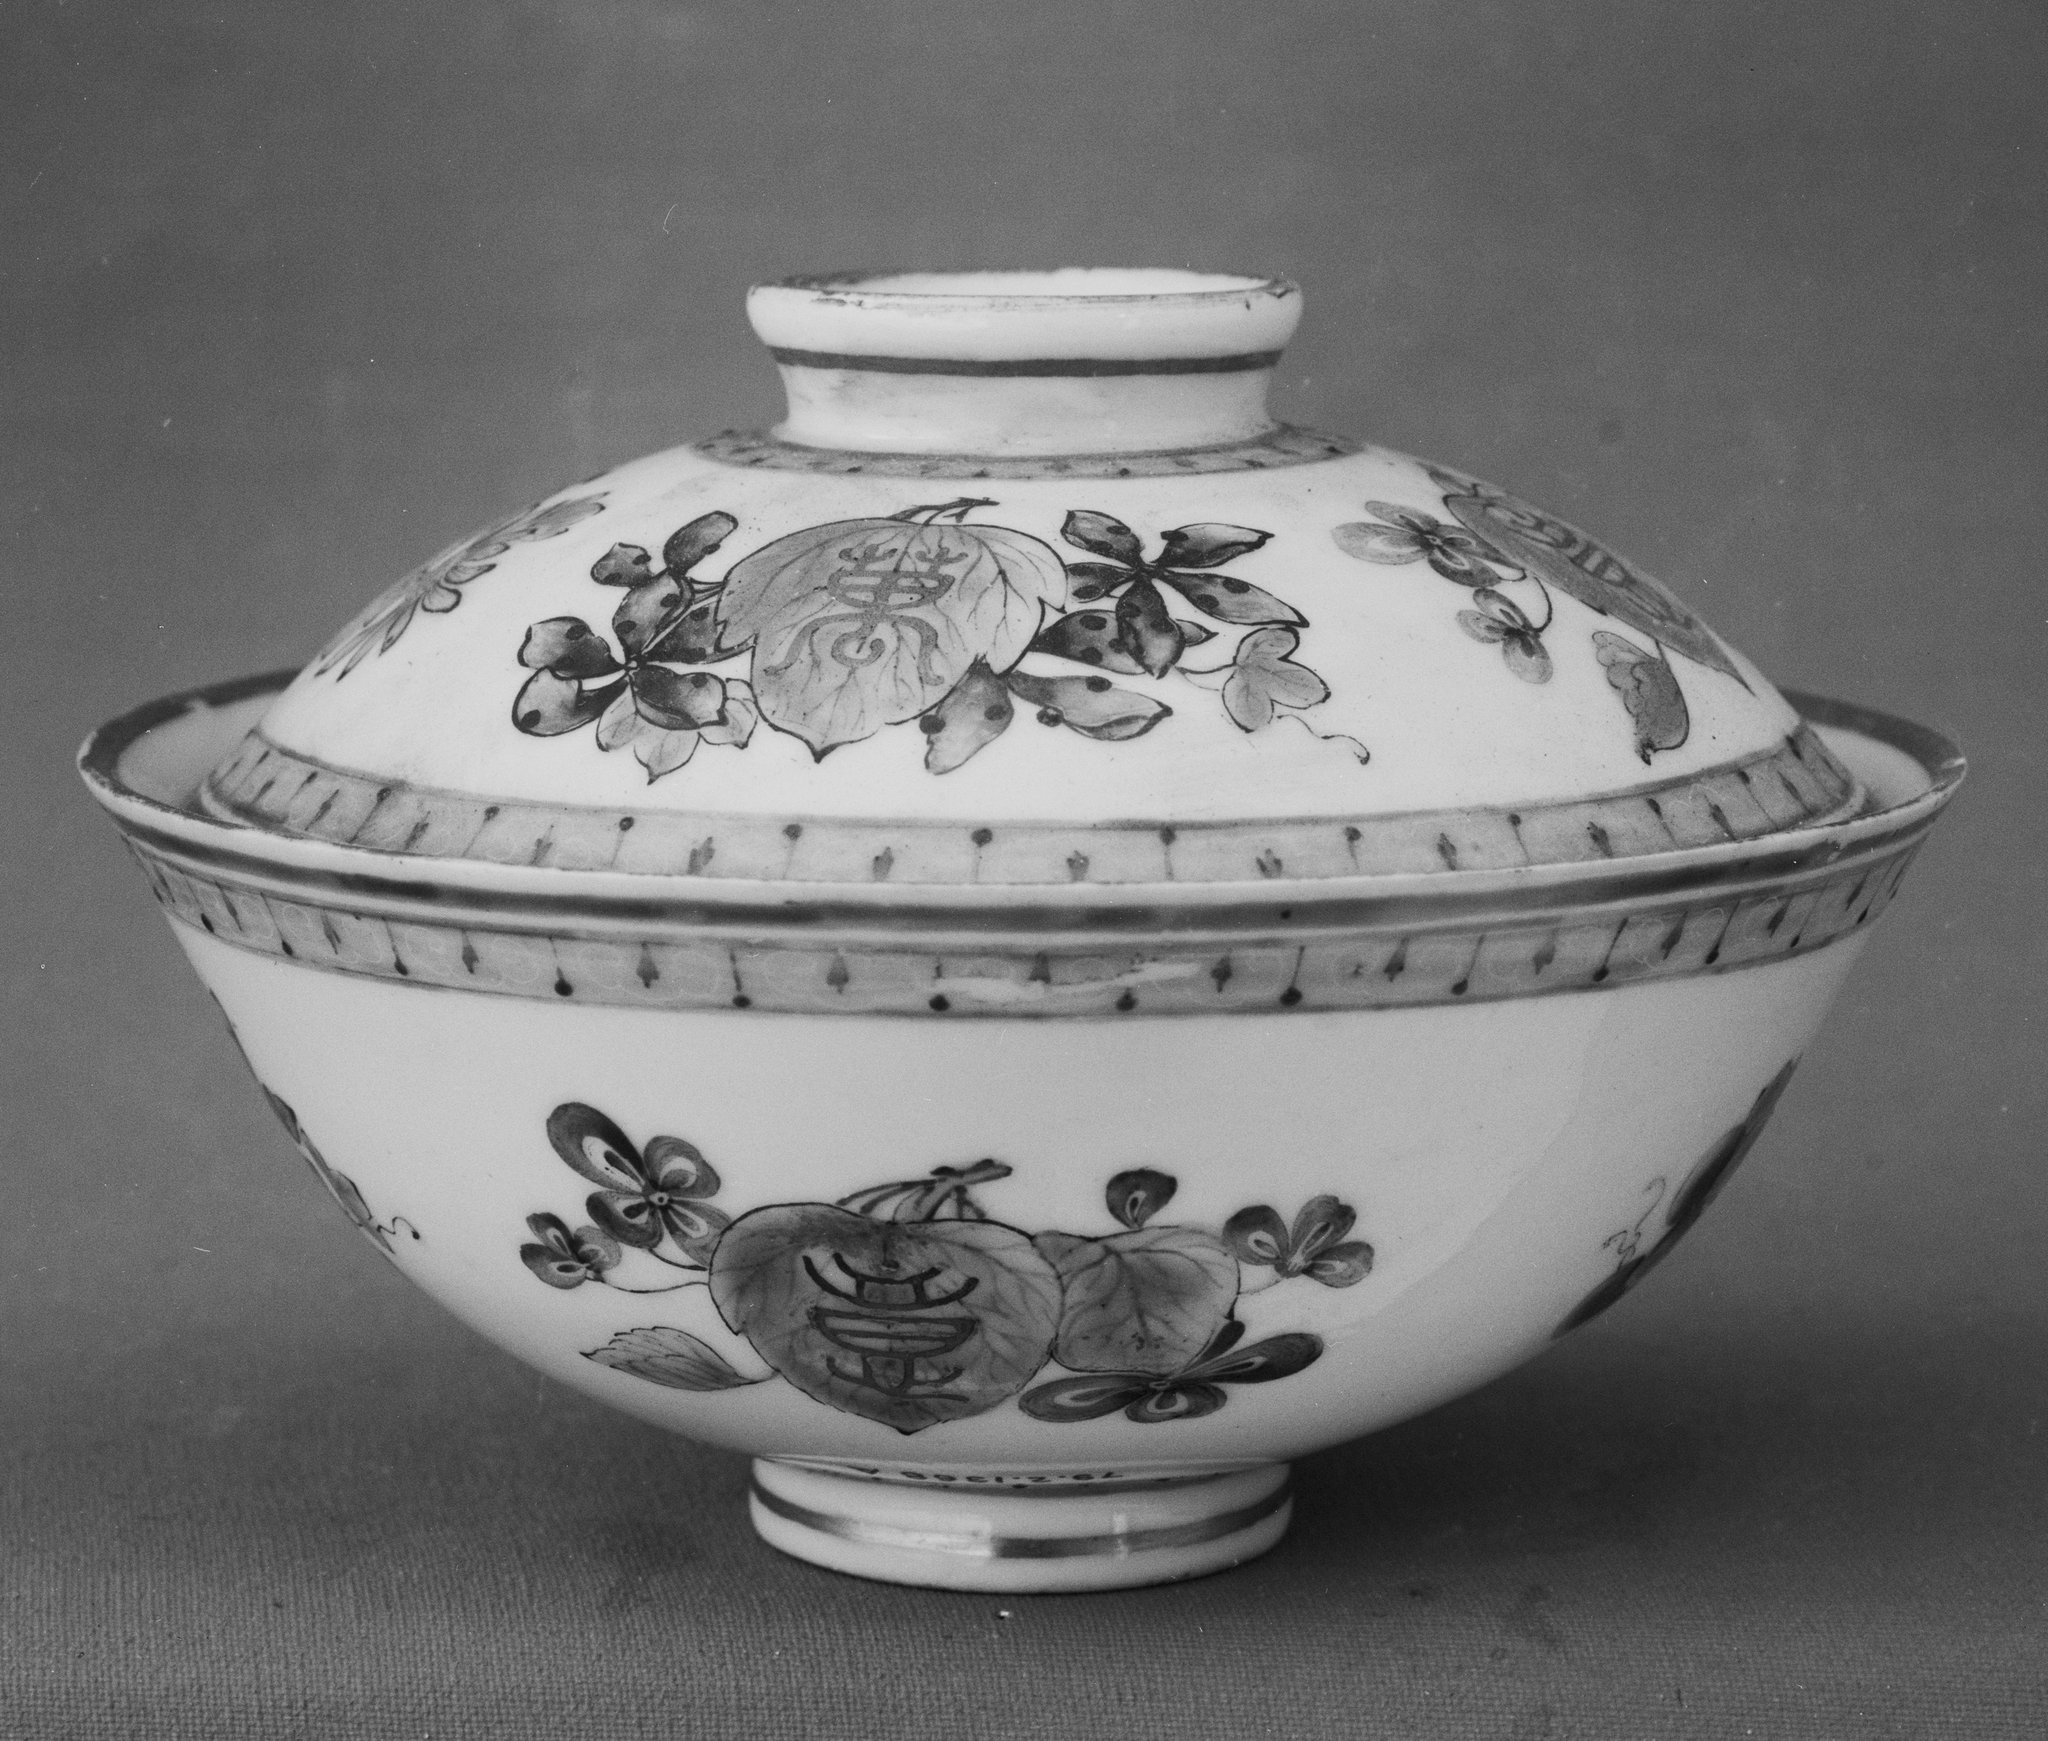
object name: covered bowl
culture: chinese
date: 1801-1850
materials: enamel, gilt, porcelain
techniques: overglaze, painting, polychrome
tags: flowers,leaves